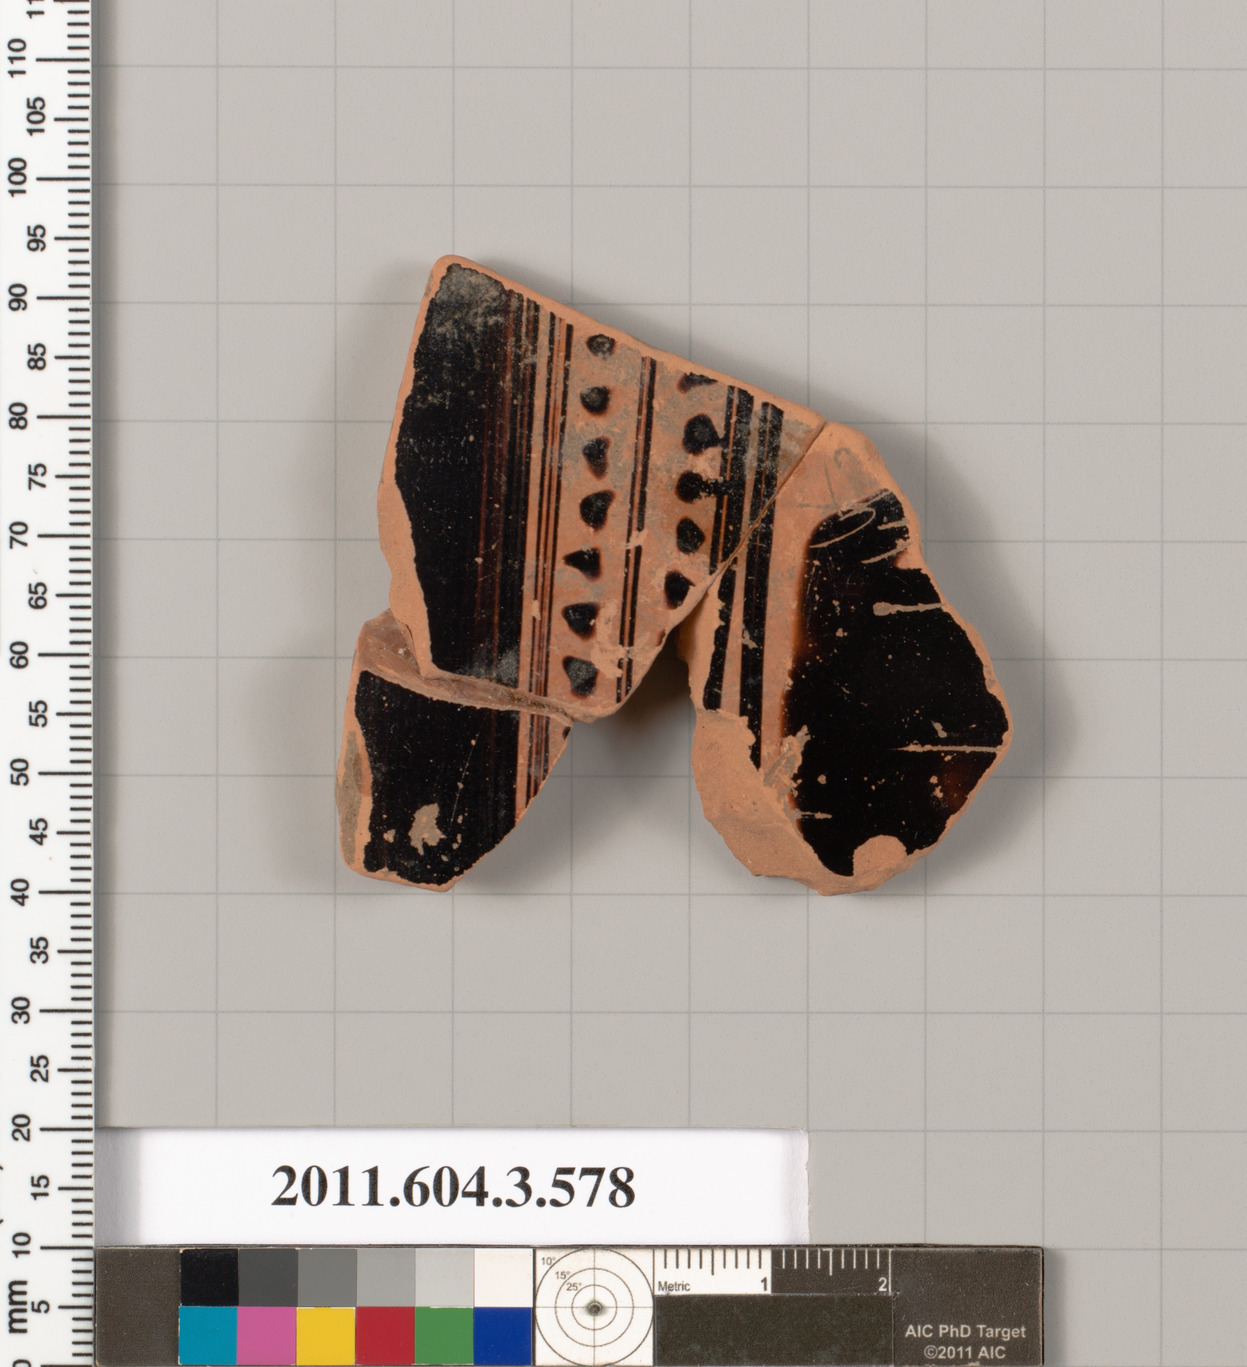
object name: column krater fragment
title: Terracotta fragment of a column-krater (bowl for mixing wine and water)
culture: greek, attic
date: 534-501 BCE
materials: terracotta